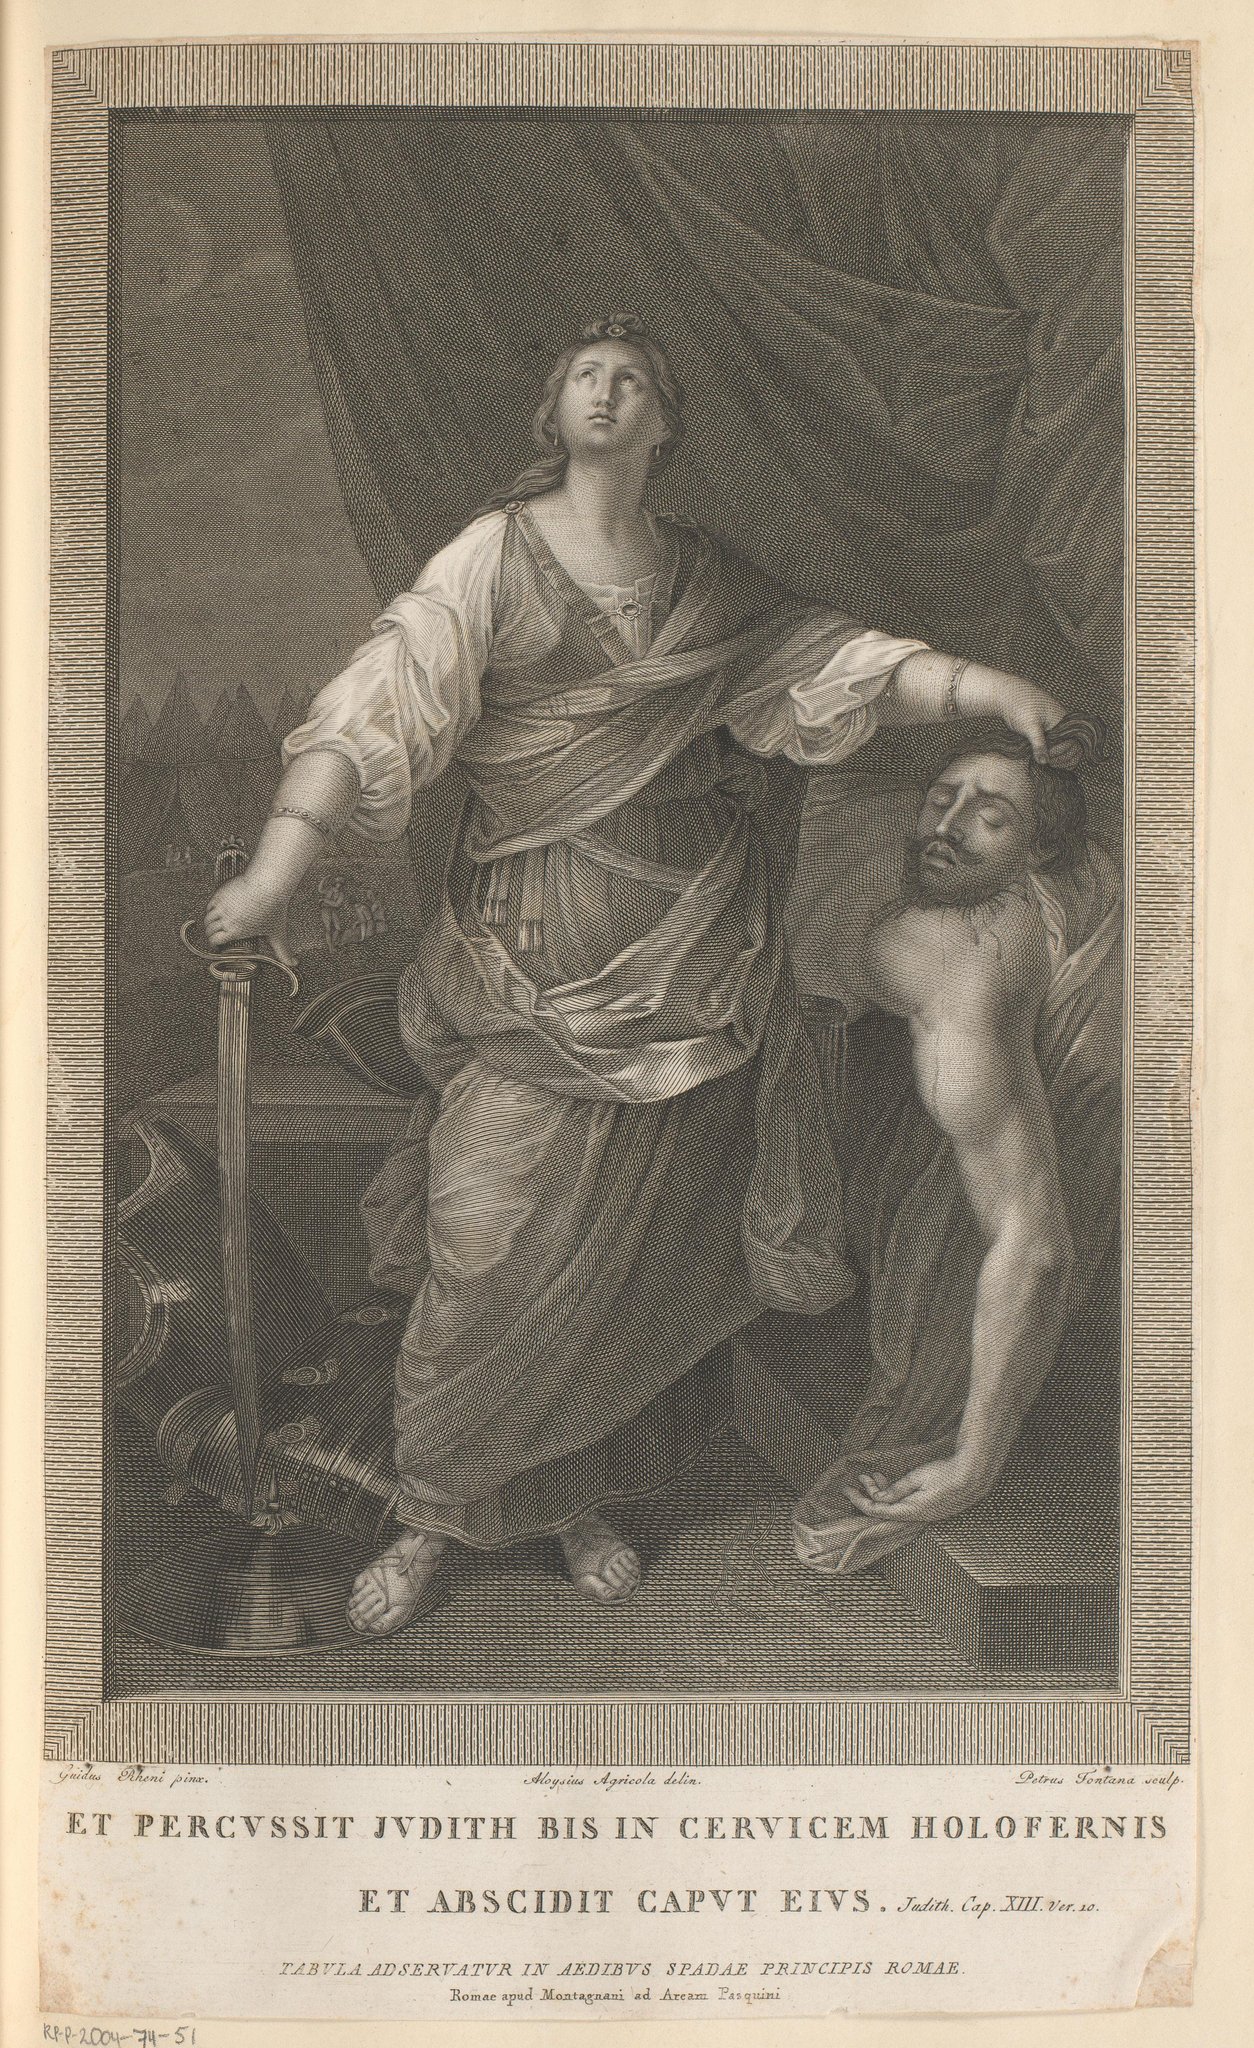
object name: album leaf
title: Judit met het hoofd van Holofernes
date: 1770-1830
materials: paper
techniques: engraving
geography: rome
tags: judith shows holofernes' head to the people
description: De samensteller heeft deze prent in het album geplakt als illustratie bij: Pilkington, Matthew en Johann Heinrich Füssli. A dictionary of painters, from the revival of the art to the present period. 4 dln. Londen: John Crowder, 1805, dl. 3, p. 436.